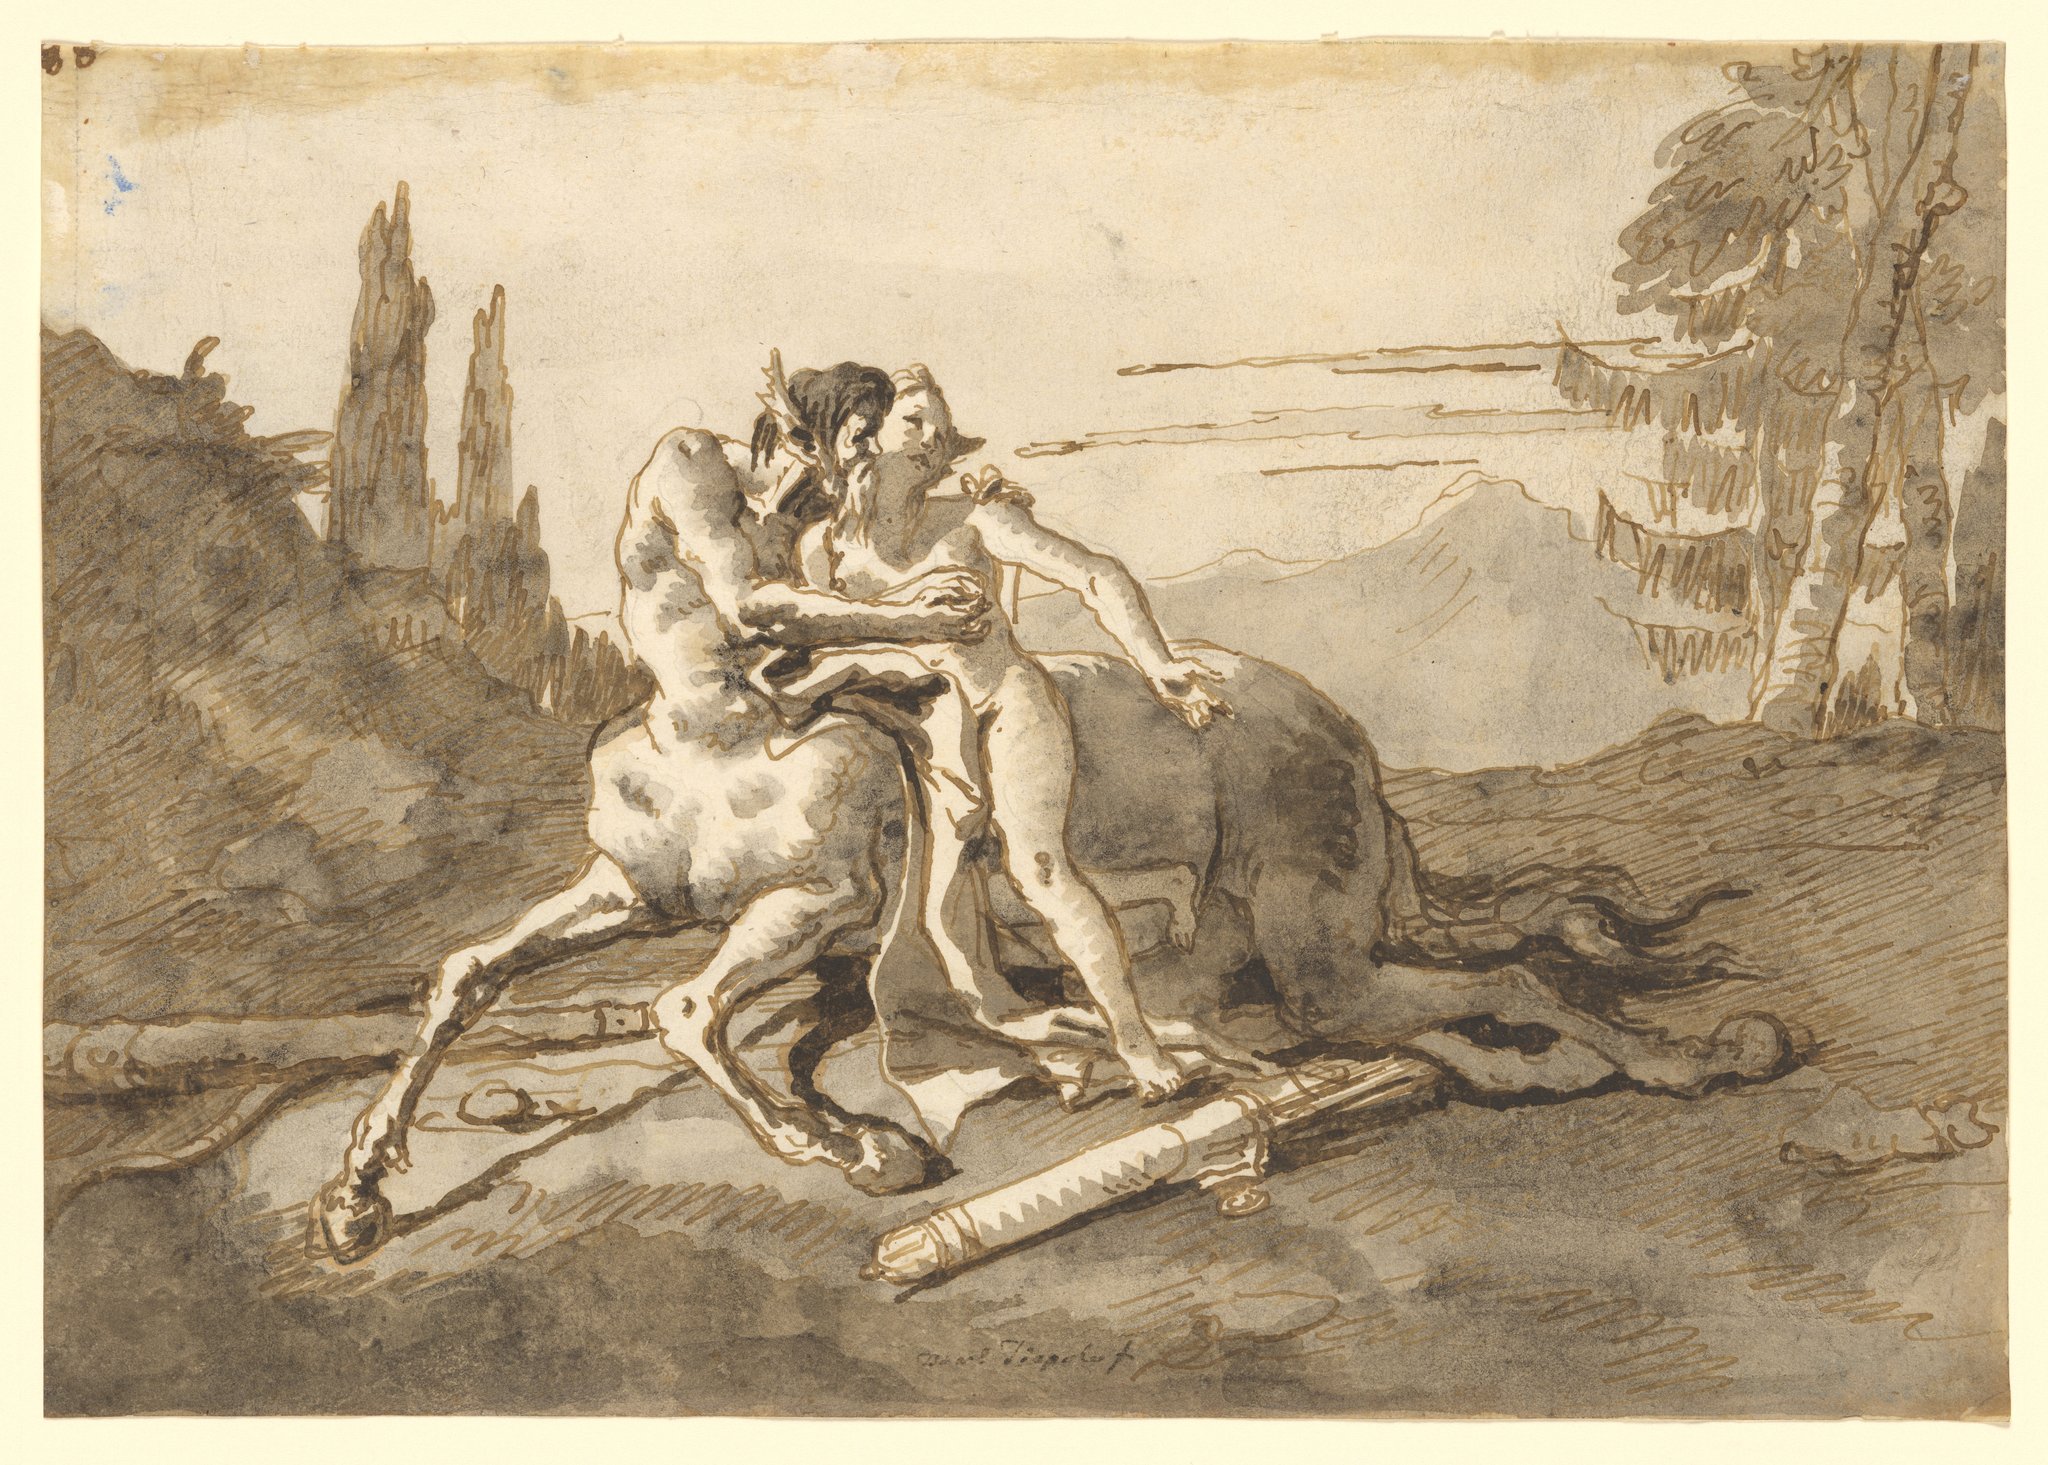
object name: drawing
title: Centaur Embracing Nymph in a Wild Landscape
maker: giovanni domenico tiepolo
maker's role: artist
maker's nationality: italian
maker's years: 1727-1804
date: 1771-1791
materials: ink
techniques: pen, wash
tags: centaurs,nymphs